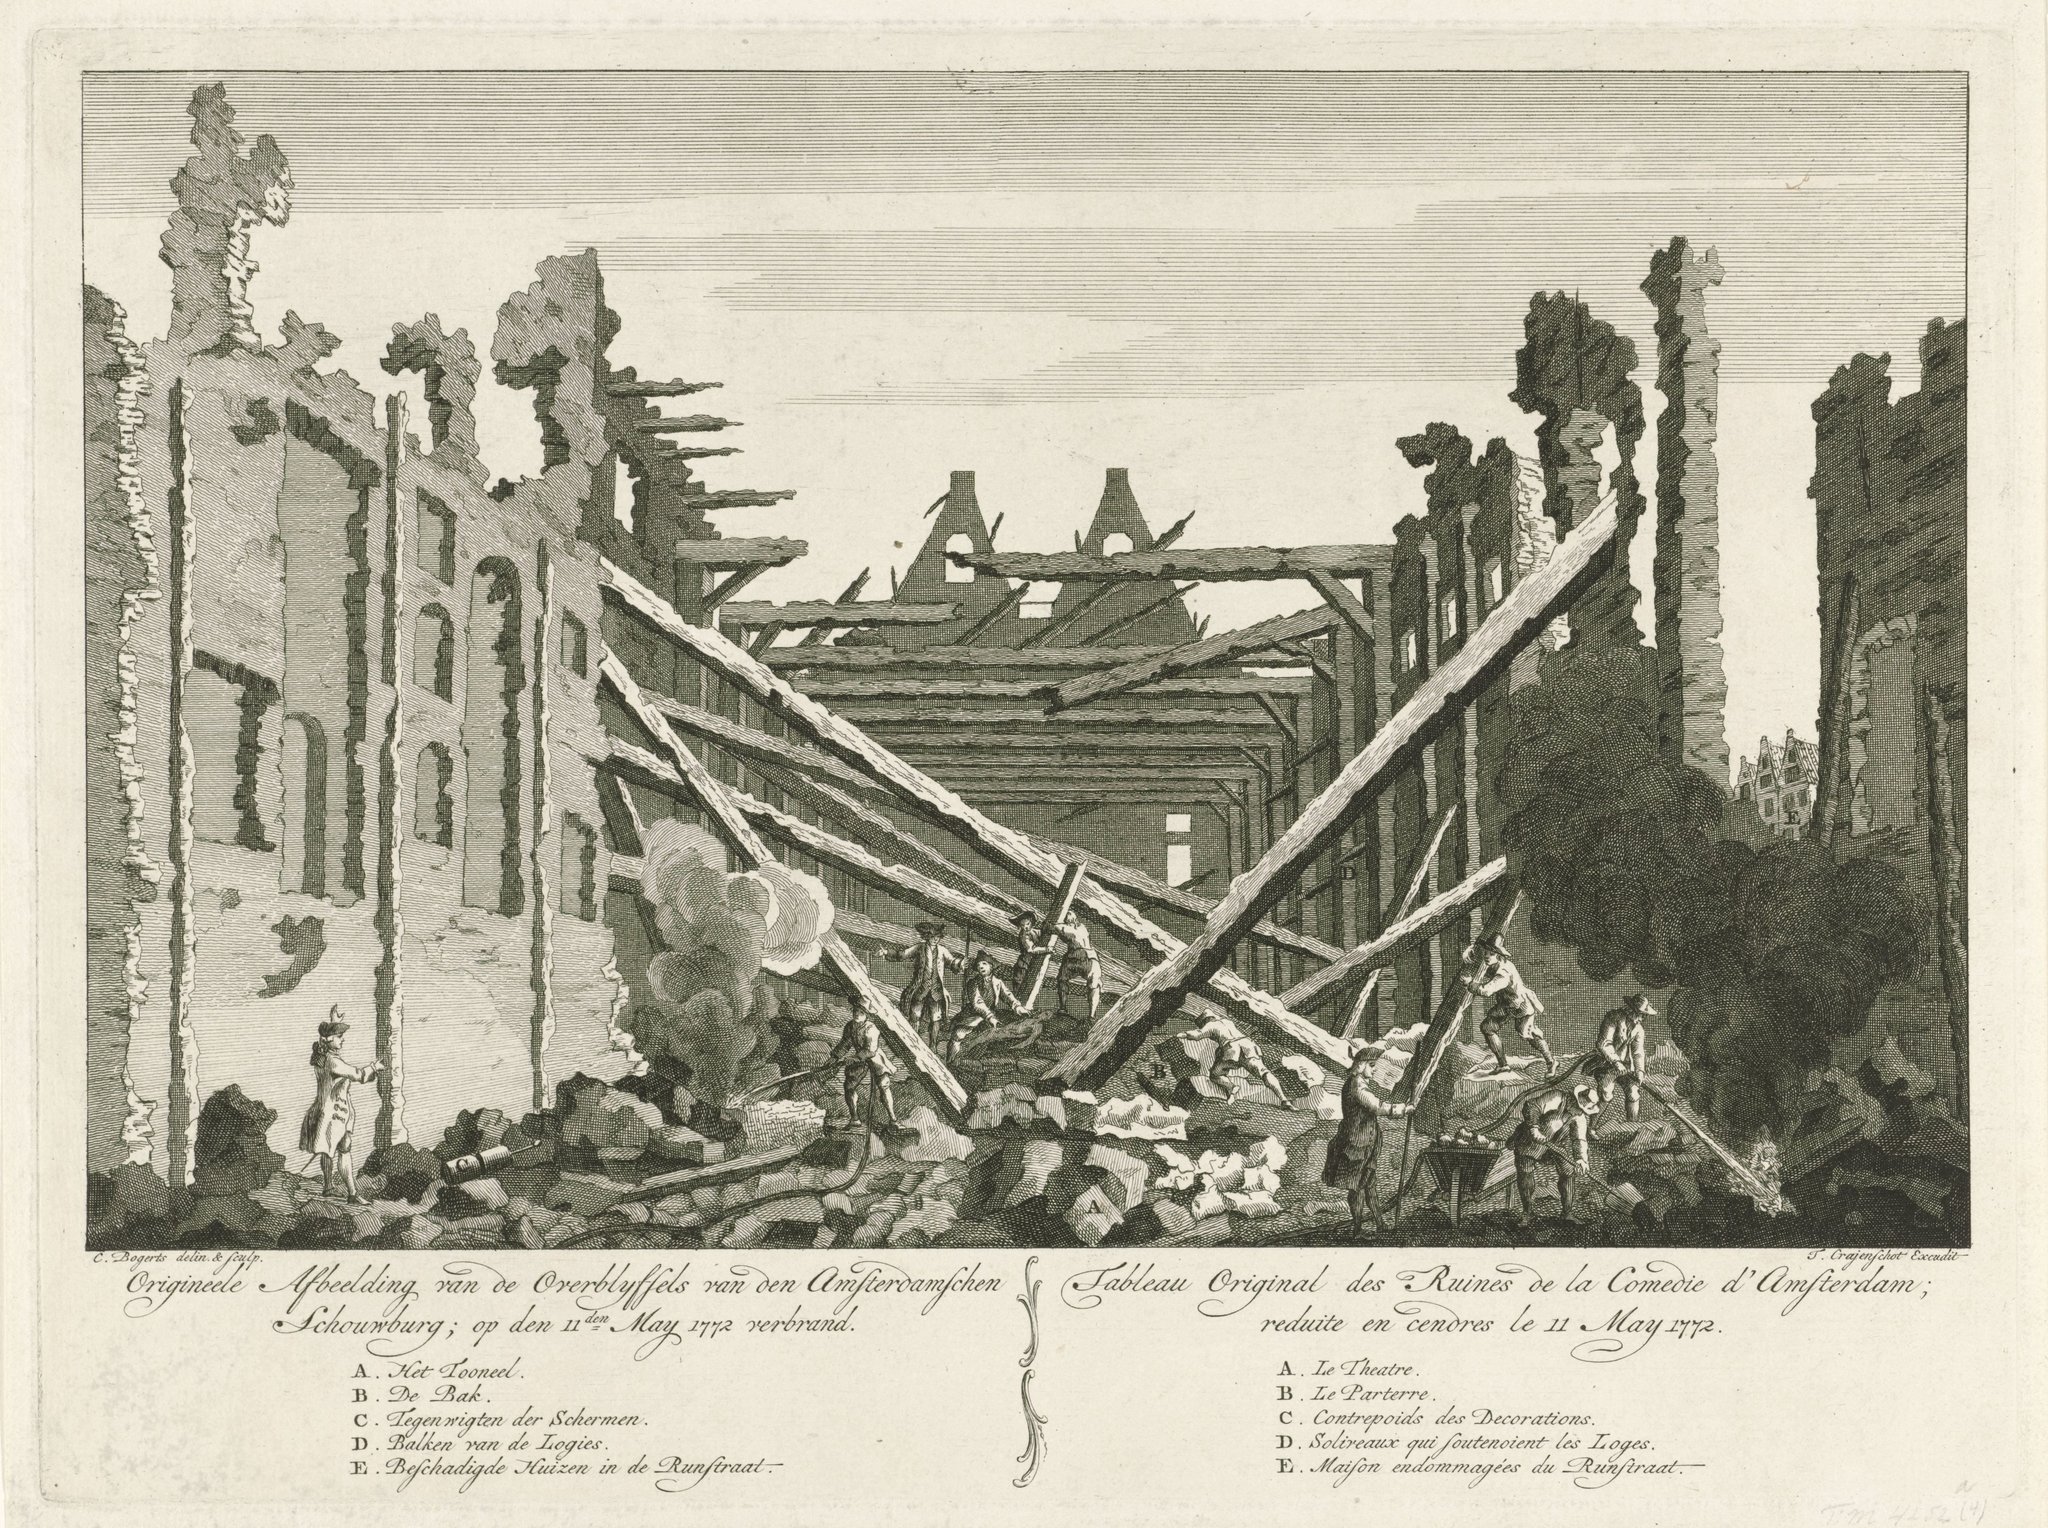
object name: print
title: Origineele Afbeelding van de Overblyfsels van den Amsterdamschen Schouwburg; op den 11den May 1772 verbrand / Tableau Original des Ruines de la Comedie d'Amsterdam; reduite en cendres le 11 may 1772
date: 1772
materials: paper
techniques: engraving, etching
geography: amsterdam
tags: on fire, ablaze, theatre, theatrical performance, ruin of a building ~ architecture, theatre (building), fire-fighting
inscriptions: collector's mark: Lugt 2228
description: Gezicht op de ruïne van de Amsterdamse Schouwburg aan de Keizersgracht na de brand van 11 mei 1772. Brandweerlieden blussen met waterspuiten de laatste vuurhaarden, anderen ruimen puin. Onder de voorstelling de titel en legenda A-E in het Nederlands (links) en Frans (rechts). Onderdeel van een serie van vier prenten met titelprent over de brand in de Amsterdamse Schouwburg.